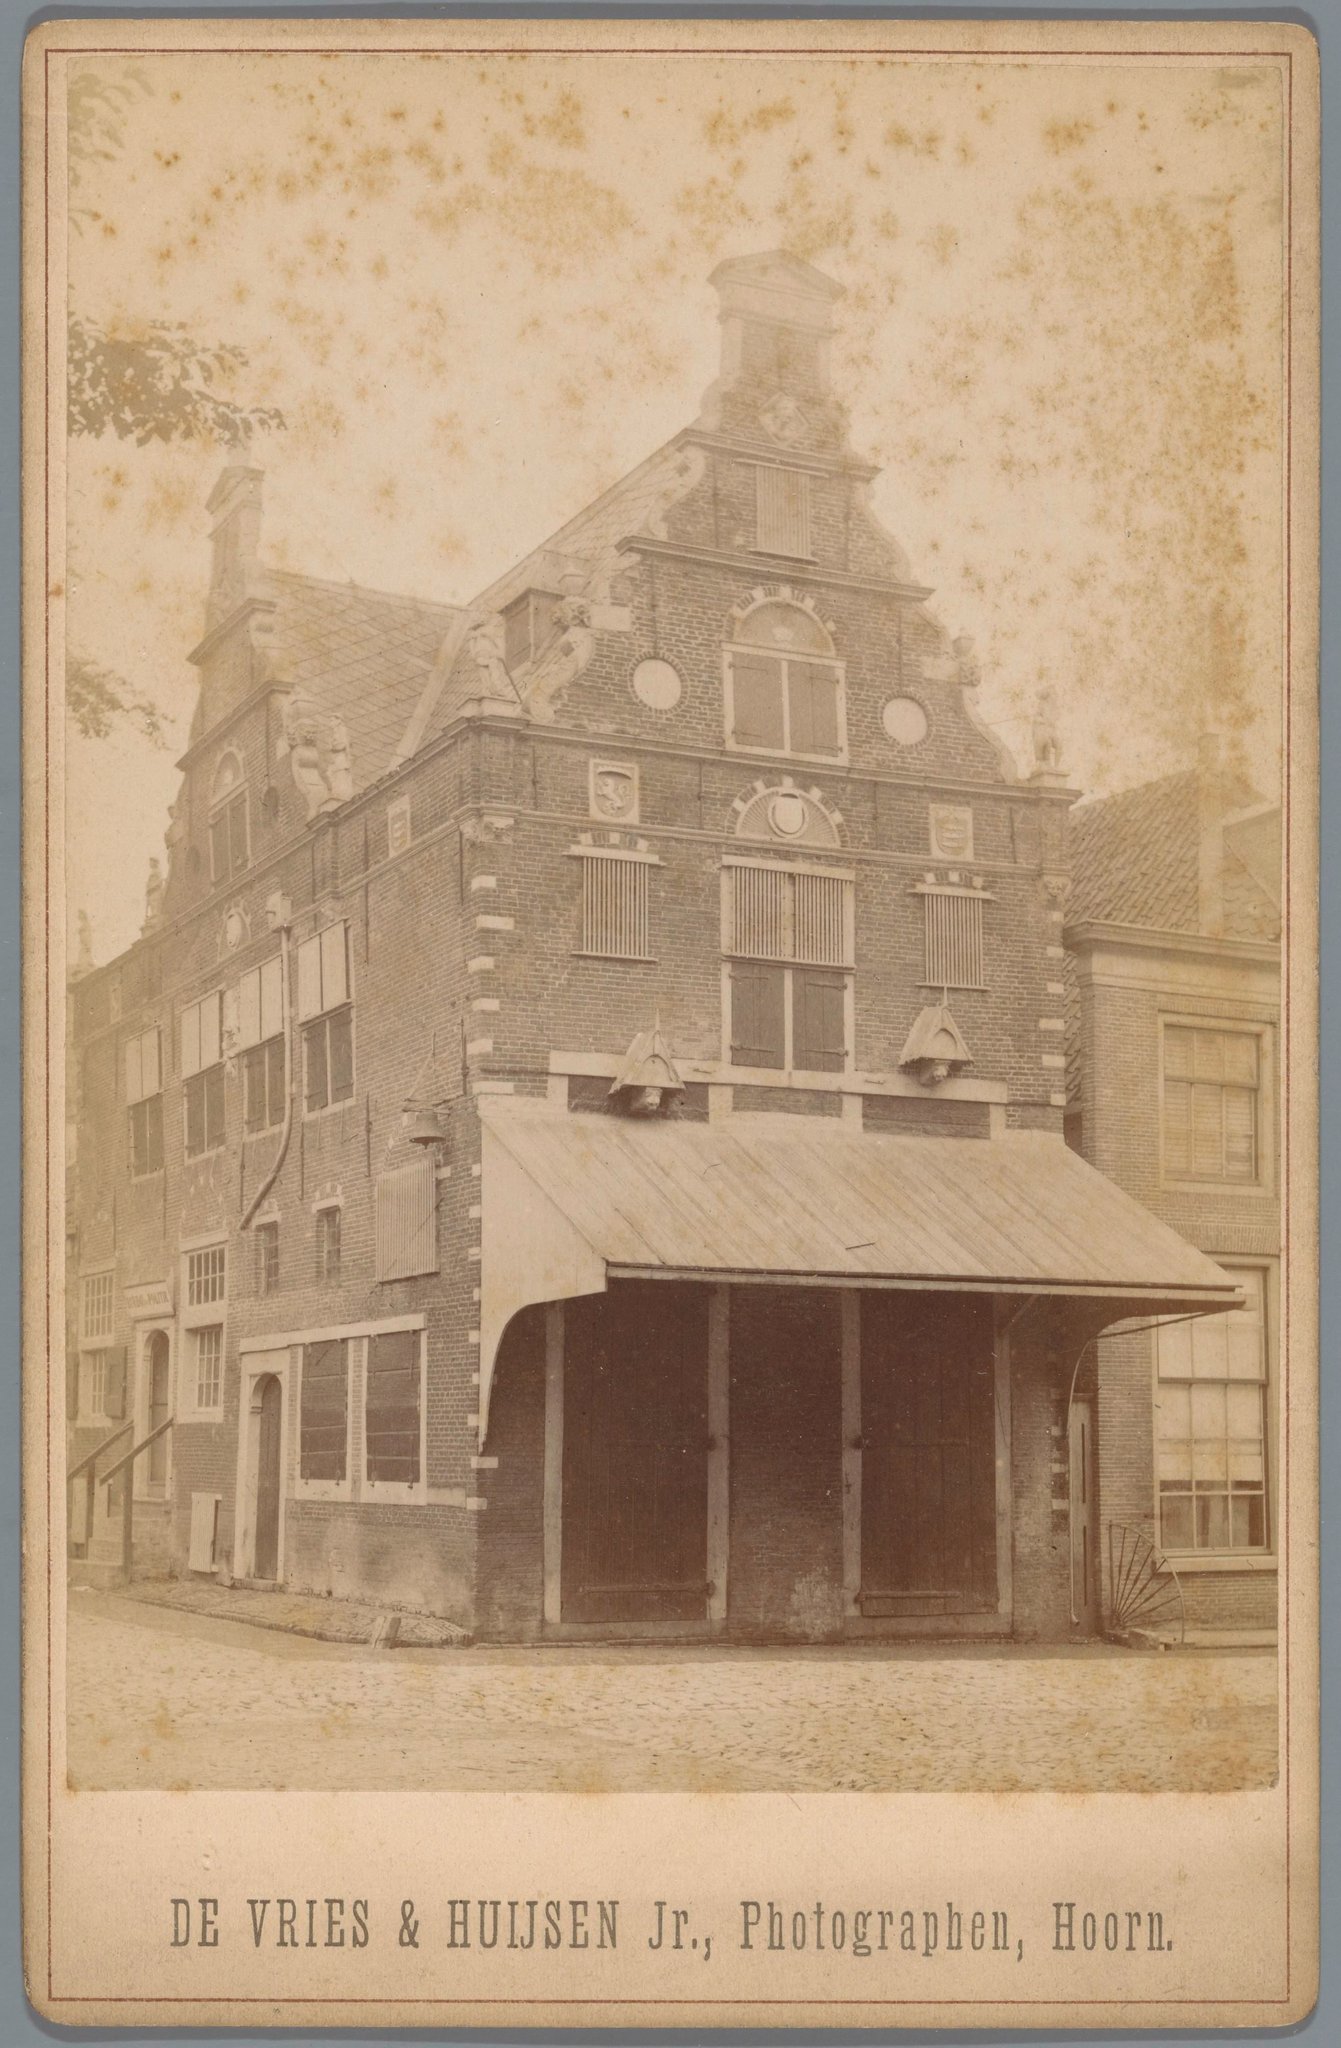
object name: cabinet photograph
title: Gezicht op het waaggebouw in Enkhuizen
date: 1878-1888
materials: cardboard, photographic support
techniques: albumen print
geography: enkhuizen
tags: weigh-house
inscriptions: annotation: ‘Stadswaag/ Enkhuizen’